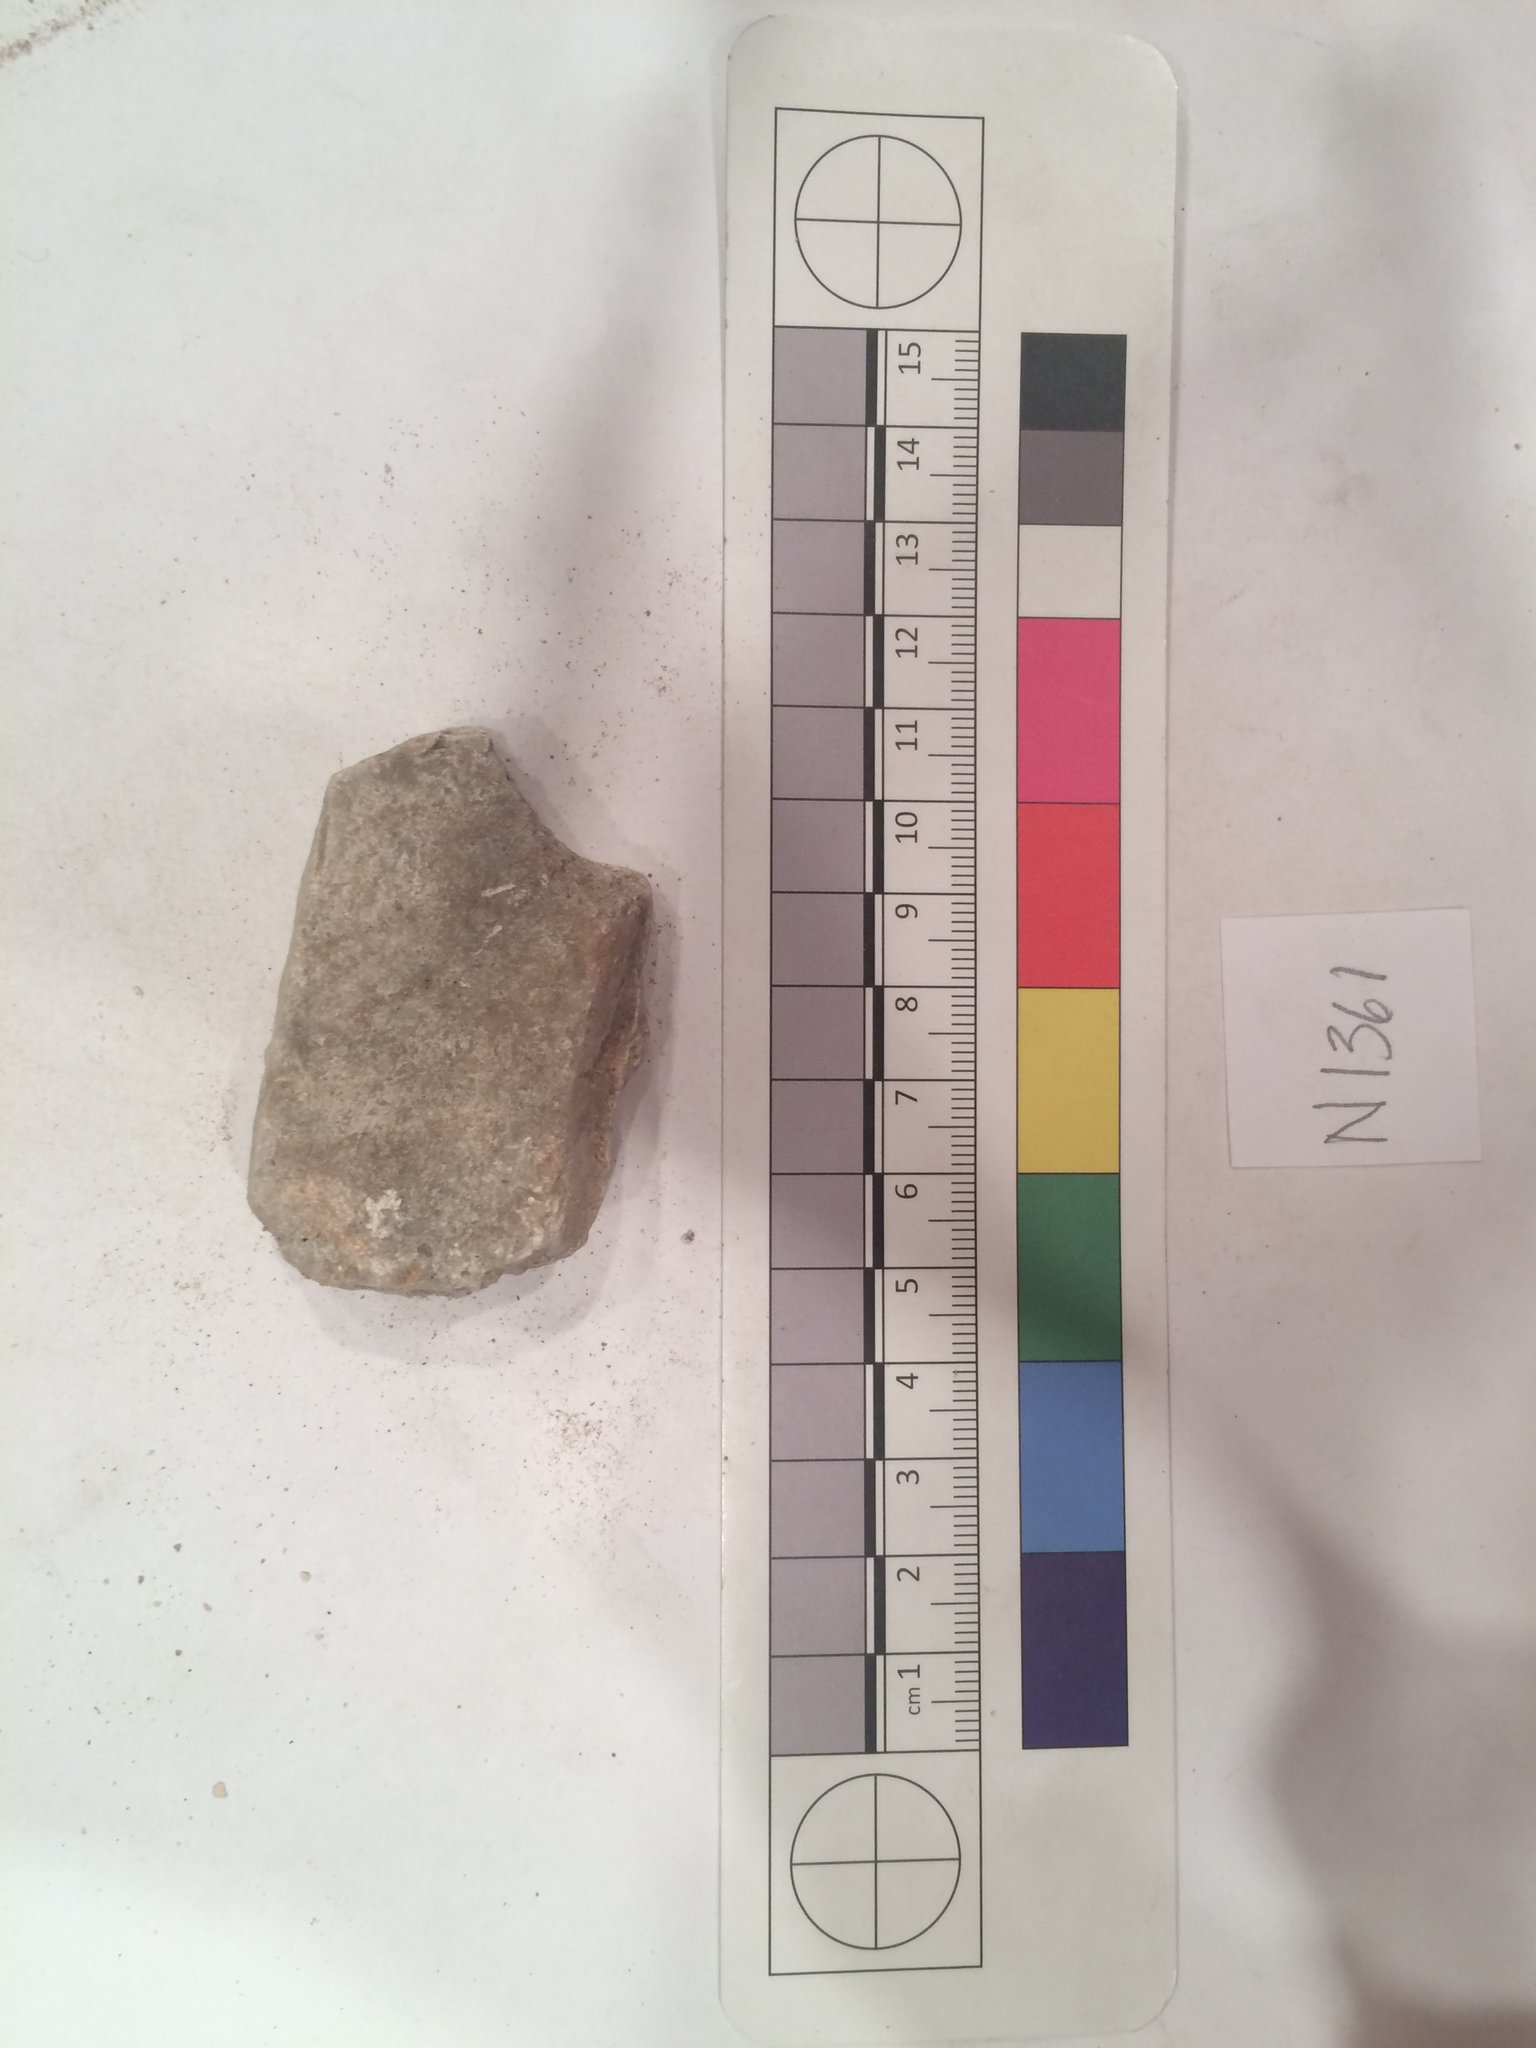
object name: fragment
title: Stucco Fragment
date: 701-1200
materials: plaster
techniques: carving, painting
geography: iran